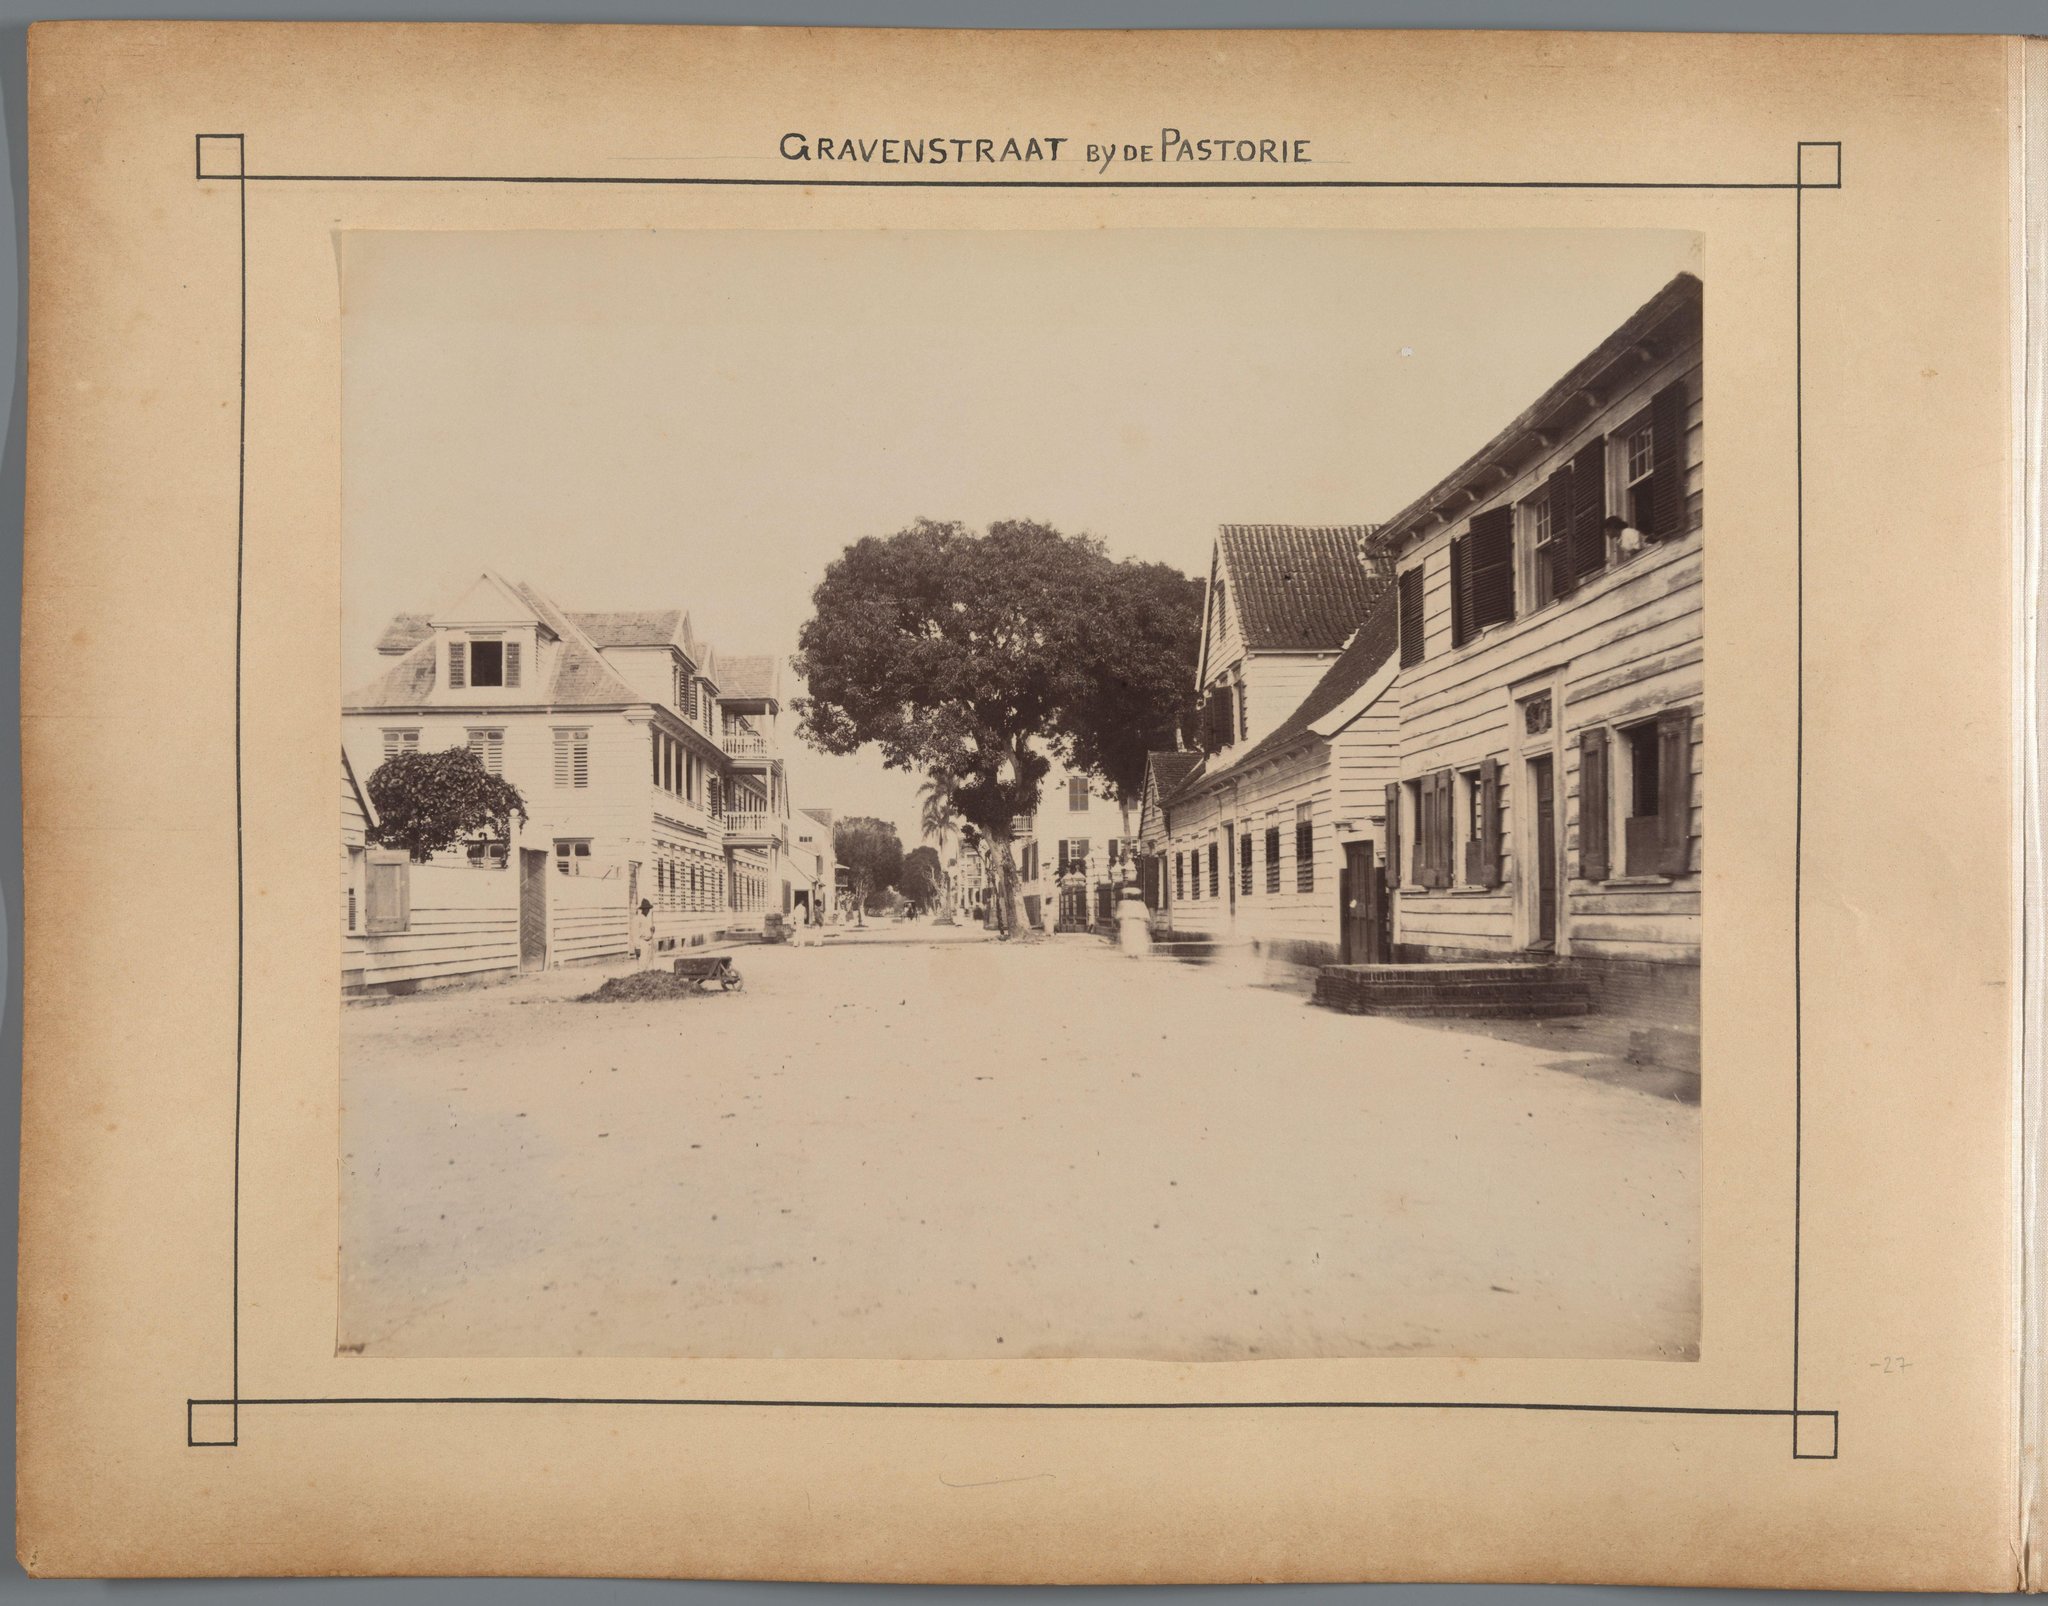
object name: photograph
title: Gravenstraat by de Pastorie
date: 1898-1902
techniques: albumen print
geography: suriname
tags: street, suriname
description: Gezicht in de Gravenstraat (nu Henck Arronstraat) in Paramaribo.